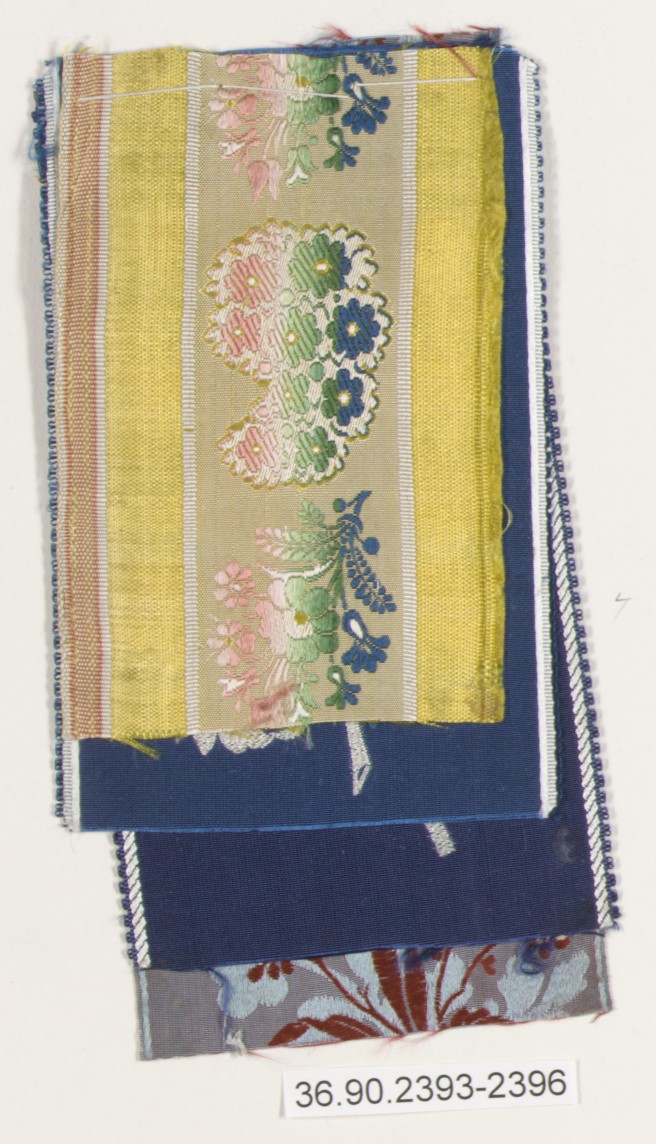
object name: ribbon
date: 1801-1900